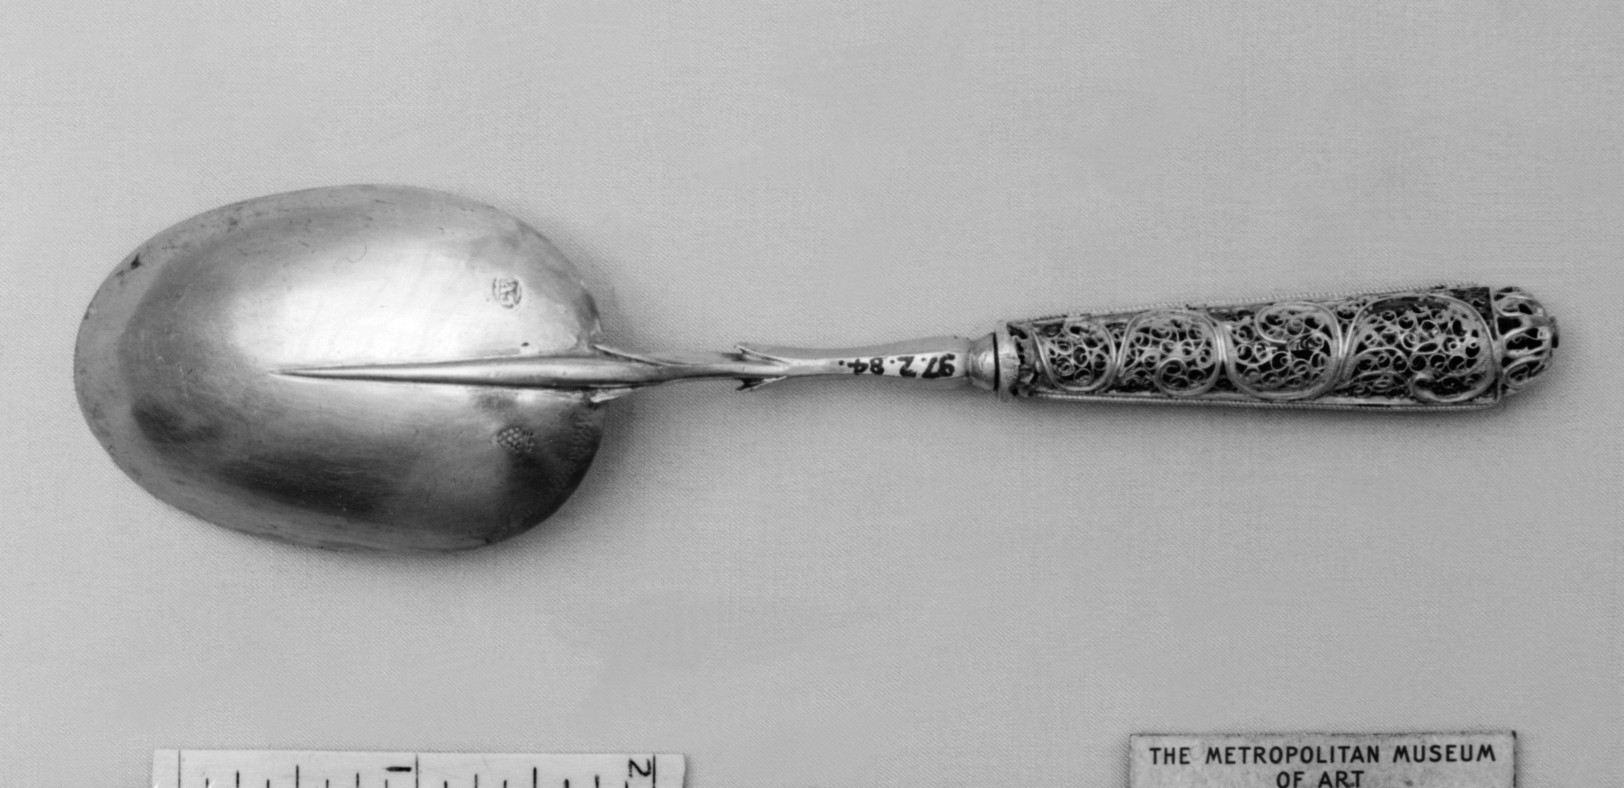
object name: spoon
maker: christian winter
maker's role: maker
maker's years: 1661-1737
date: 1700-1705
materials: gilt, silver